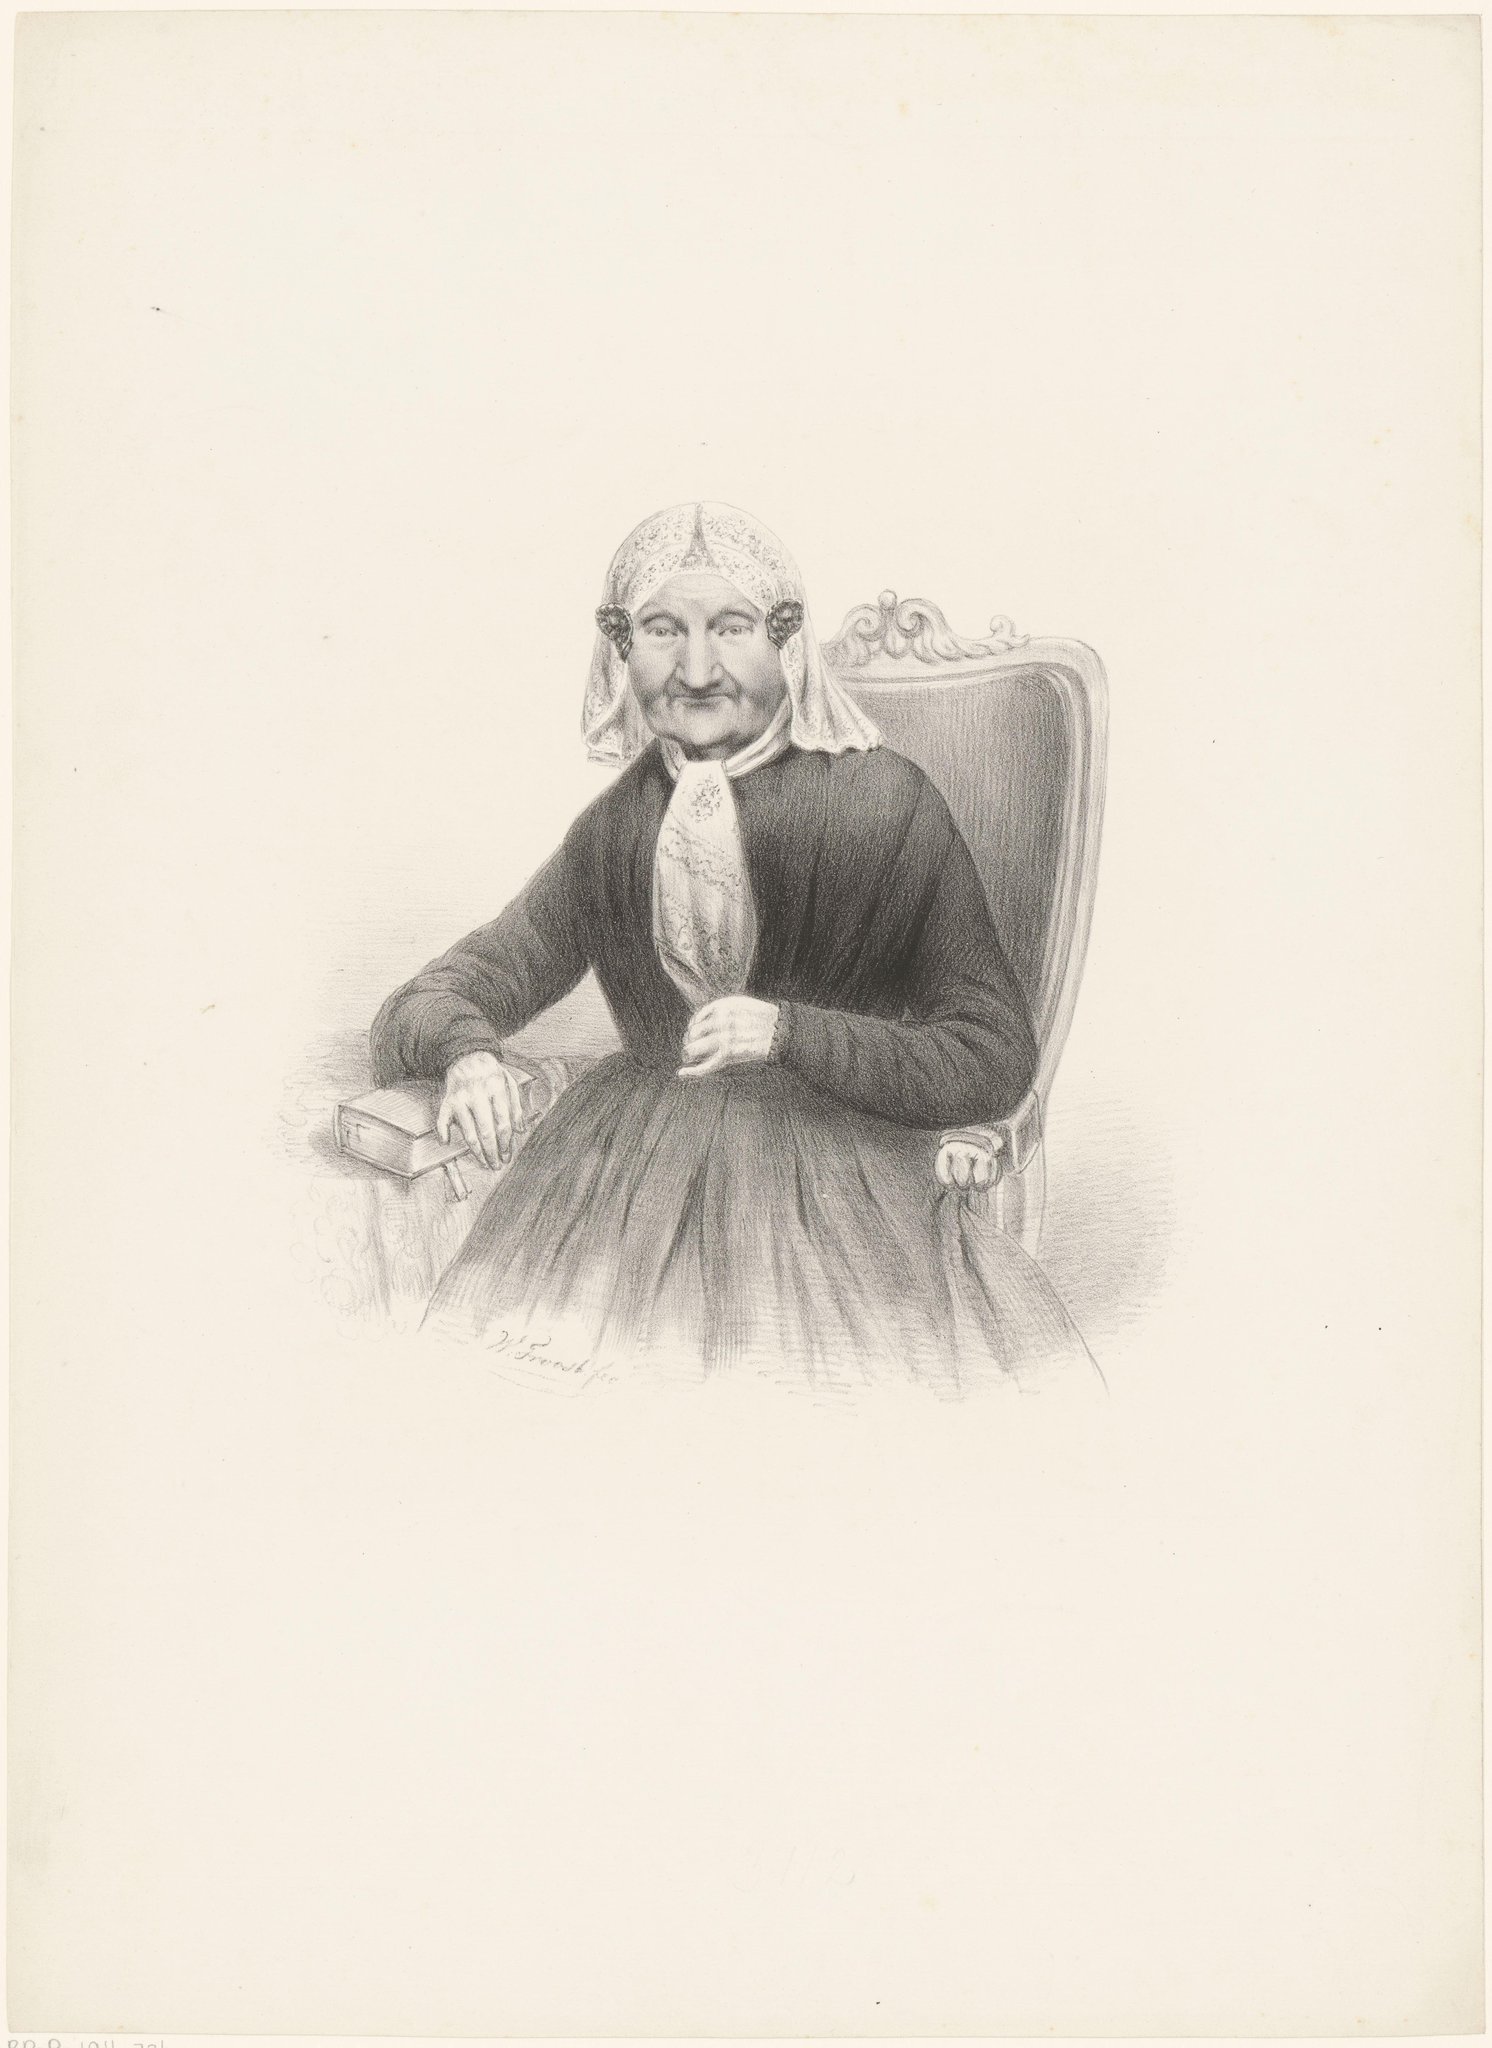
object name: print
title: Portret van onbekende vrouw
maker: willem troost (ii)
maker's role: draughtsman, painter, print maker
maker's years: 1812-1893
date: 1822-1893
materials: paper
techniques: lithograph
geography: netherlands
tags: historical persons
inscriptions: collector's mark: Lugt 2228